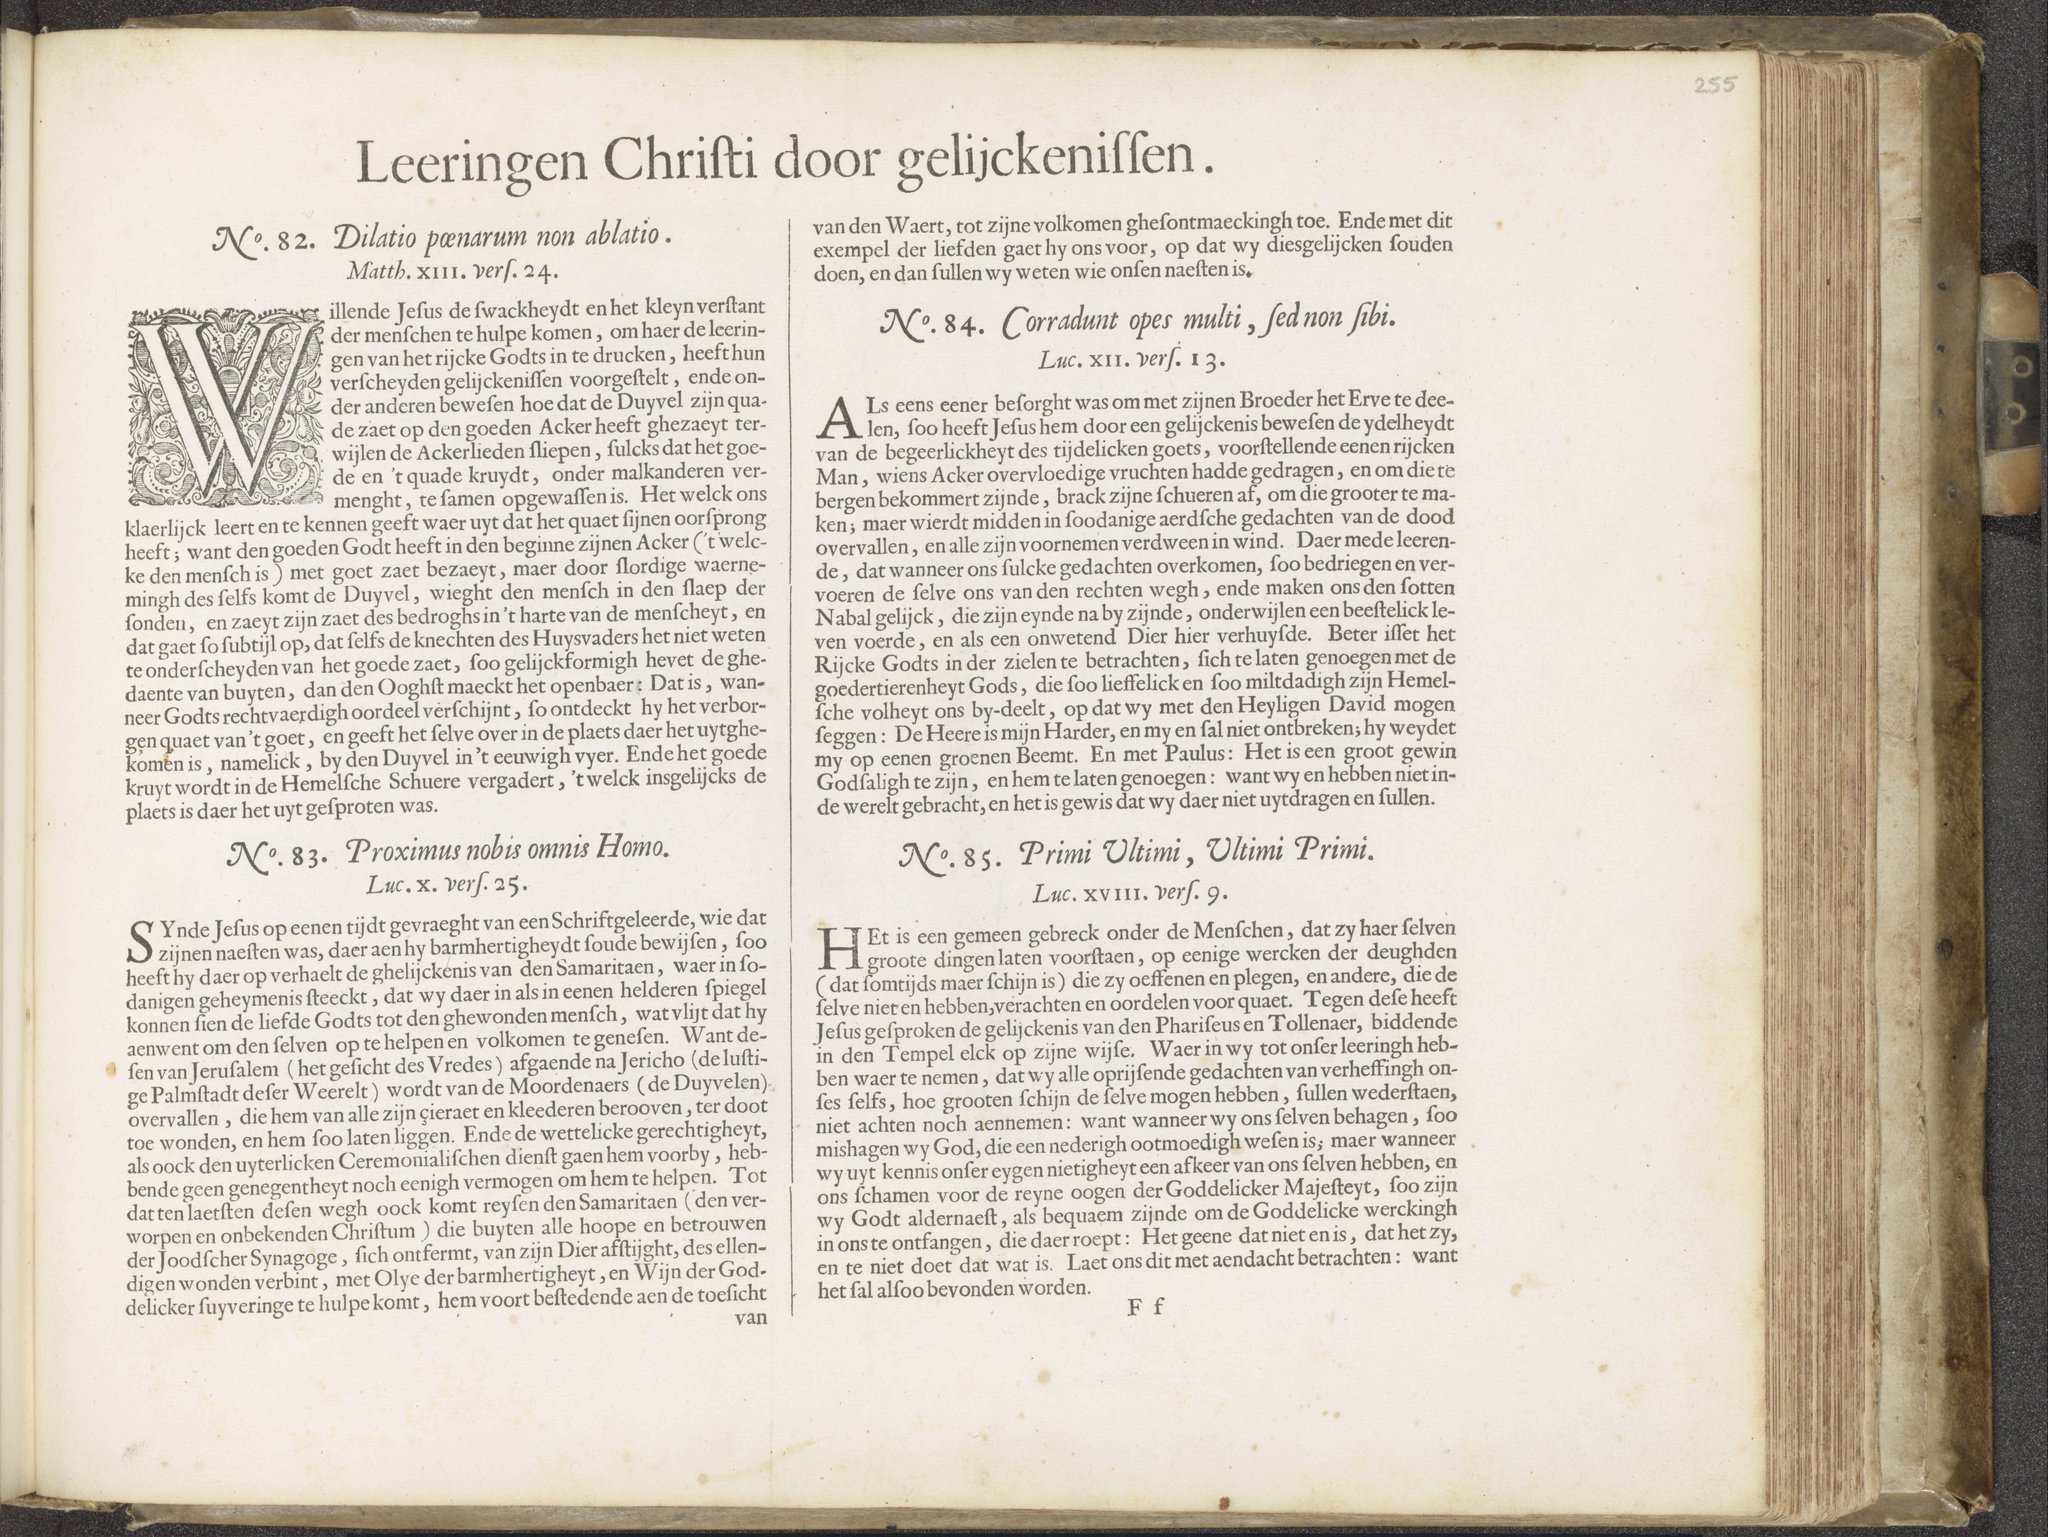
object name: album leaf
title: Den Grooten Emblemata Sacra, bestaande in meer dan vier hondert bybelsche figuren, zoo des Ouden als des Nieuwen Testaments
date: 1653-1654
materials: paper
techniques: letterpress printing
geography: amsterdam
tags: initial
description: Vier toelichtingen bij voorstellingen over de gelijkenissen van Christus, genummerd 82 tot en met 85. De tekst vangt aan met een gedecoreerde initiaal W. Het blad maakt deel uit van een album.